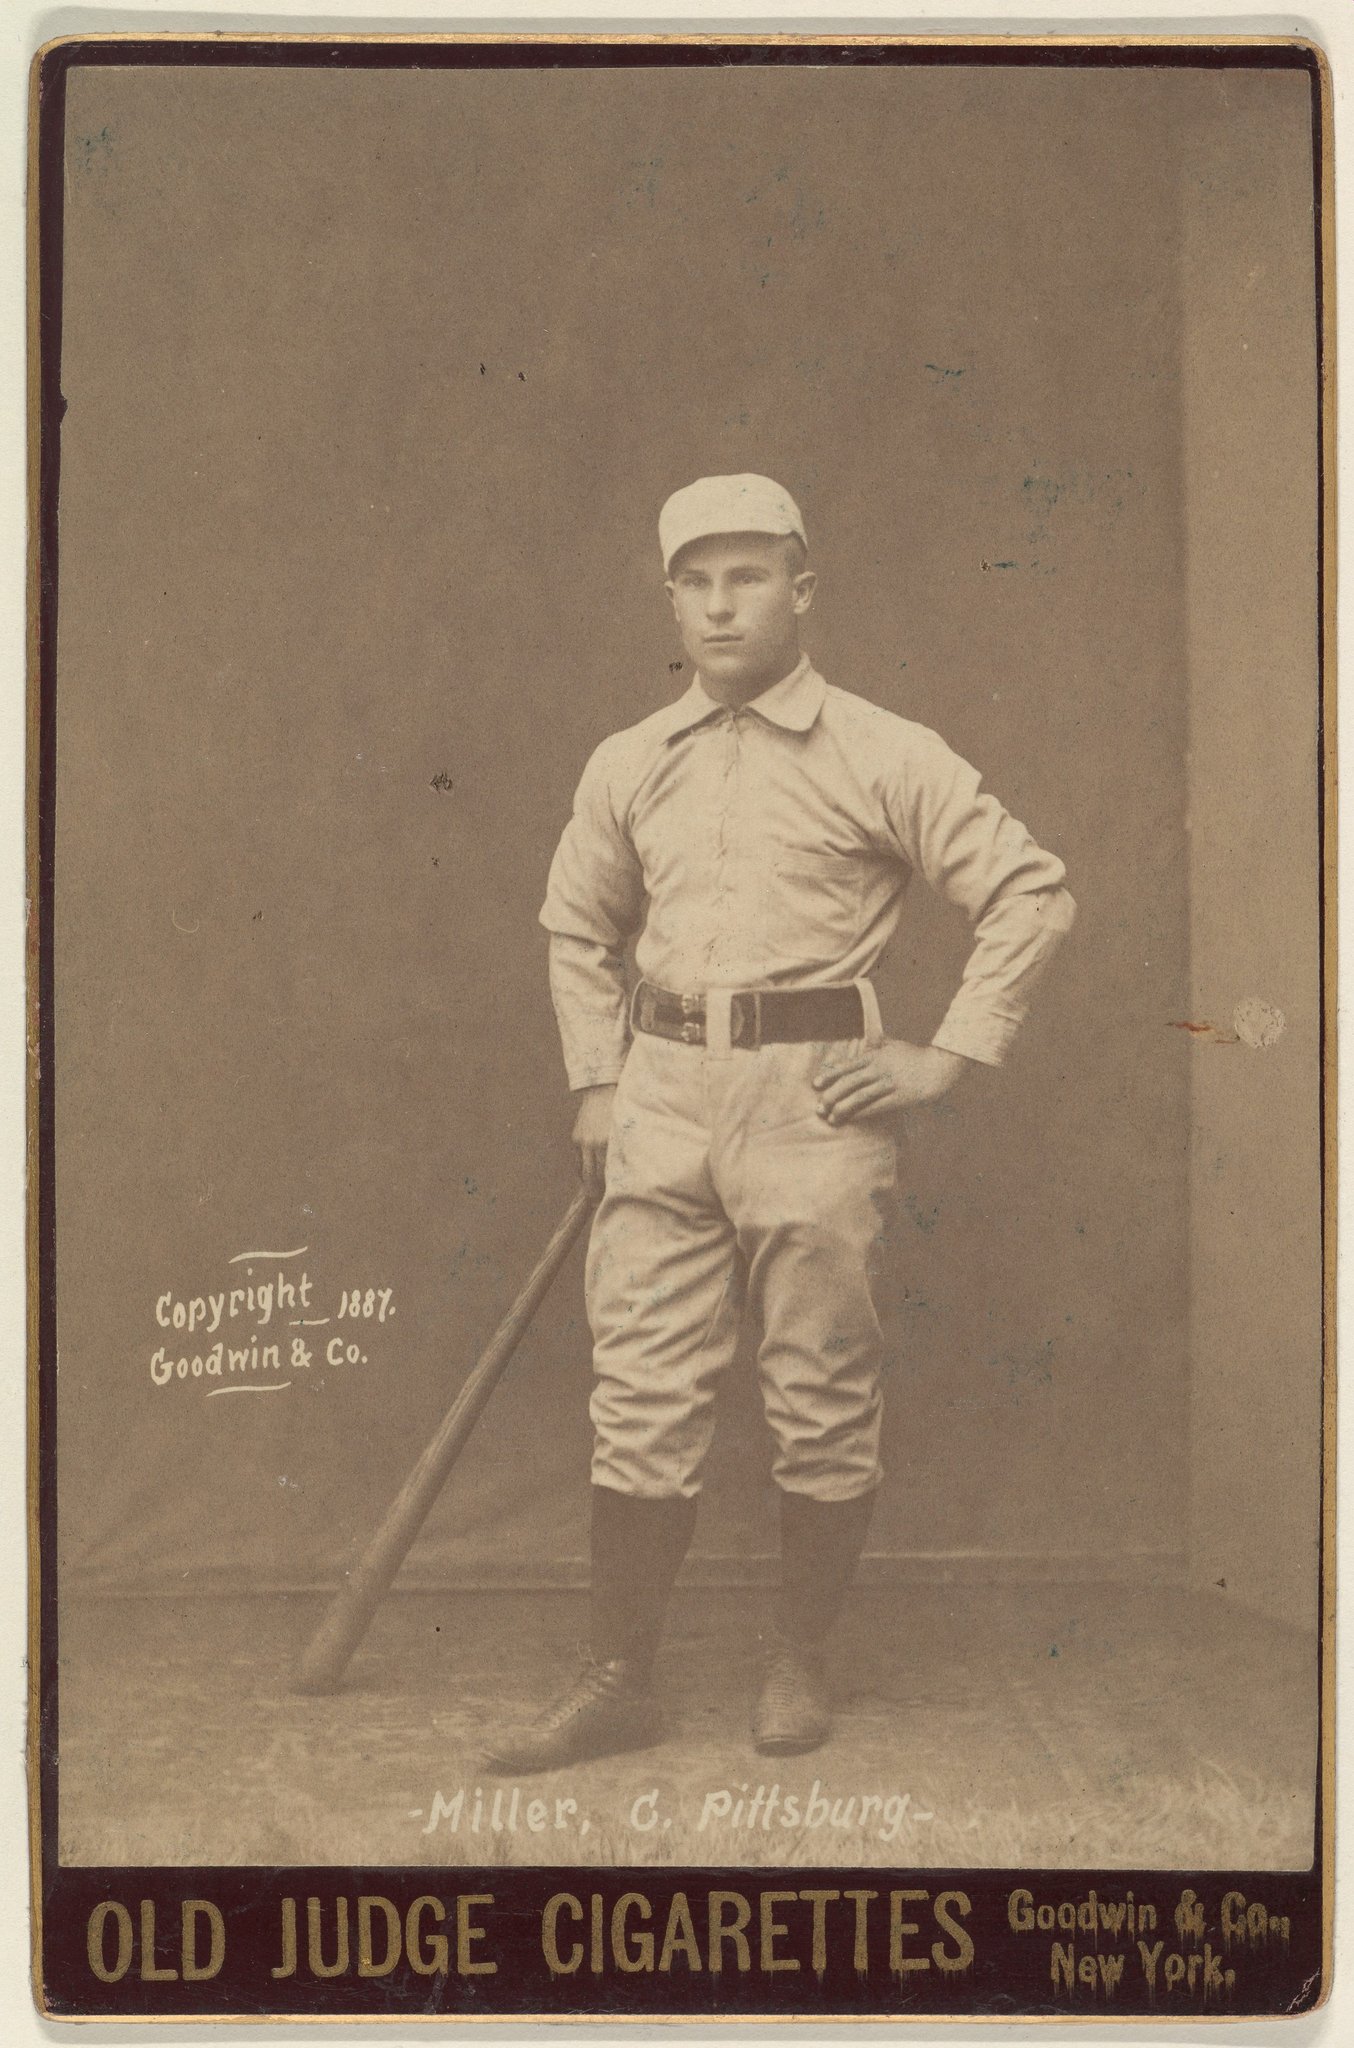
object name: baseball card, photograph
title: Miller, Catcher, Pittsburgh, from the series Old Judge Cigarettes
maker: goodwin & company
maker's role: publisher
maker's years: 1850-1950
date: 1887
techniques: albumen print, photography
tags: men,portraits,baseball,athletes